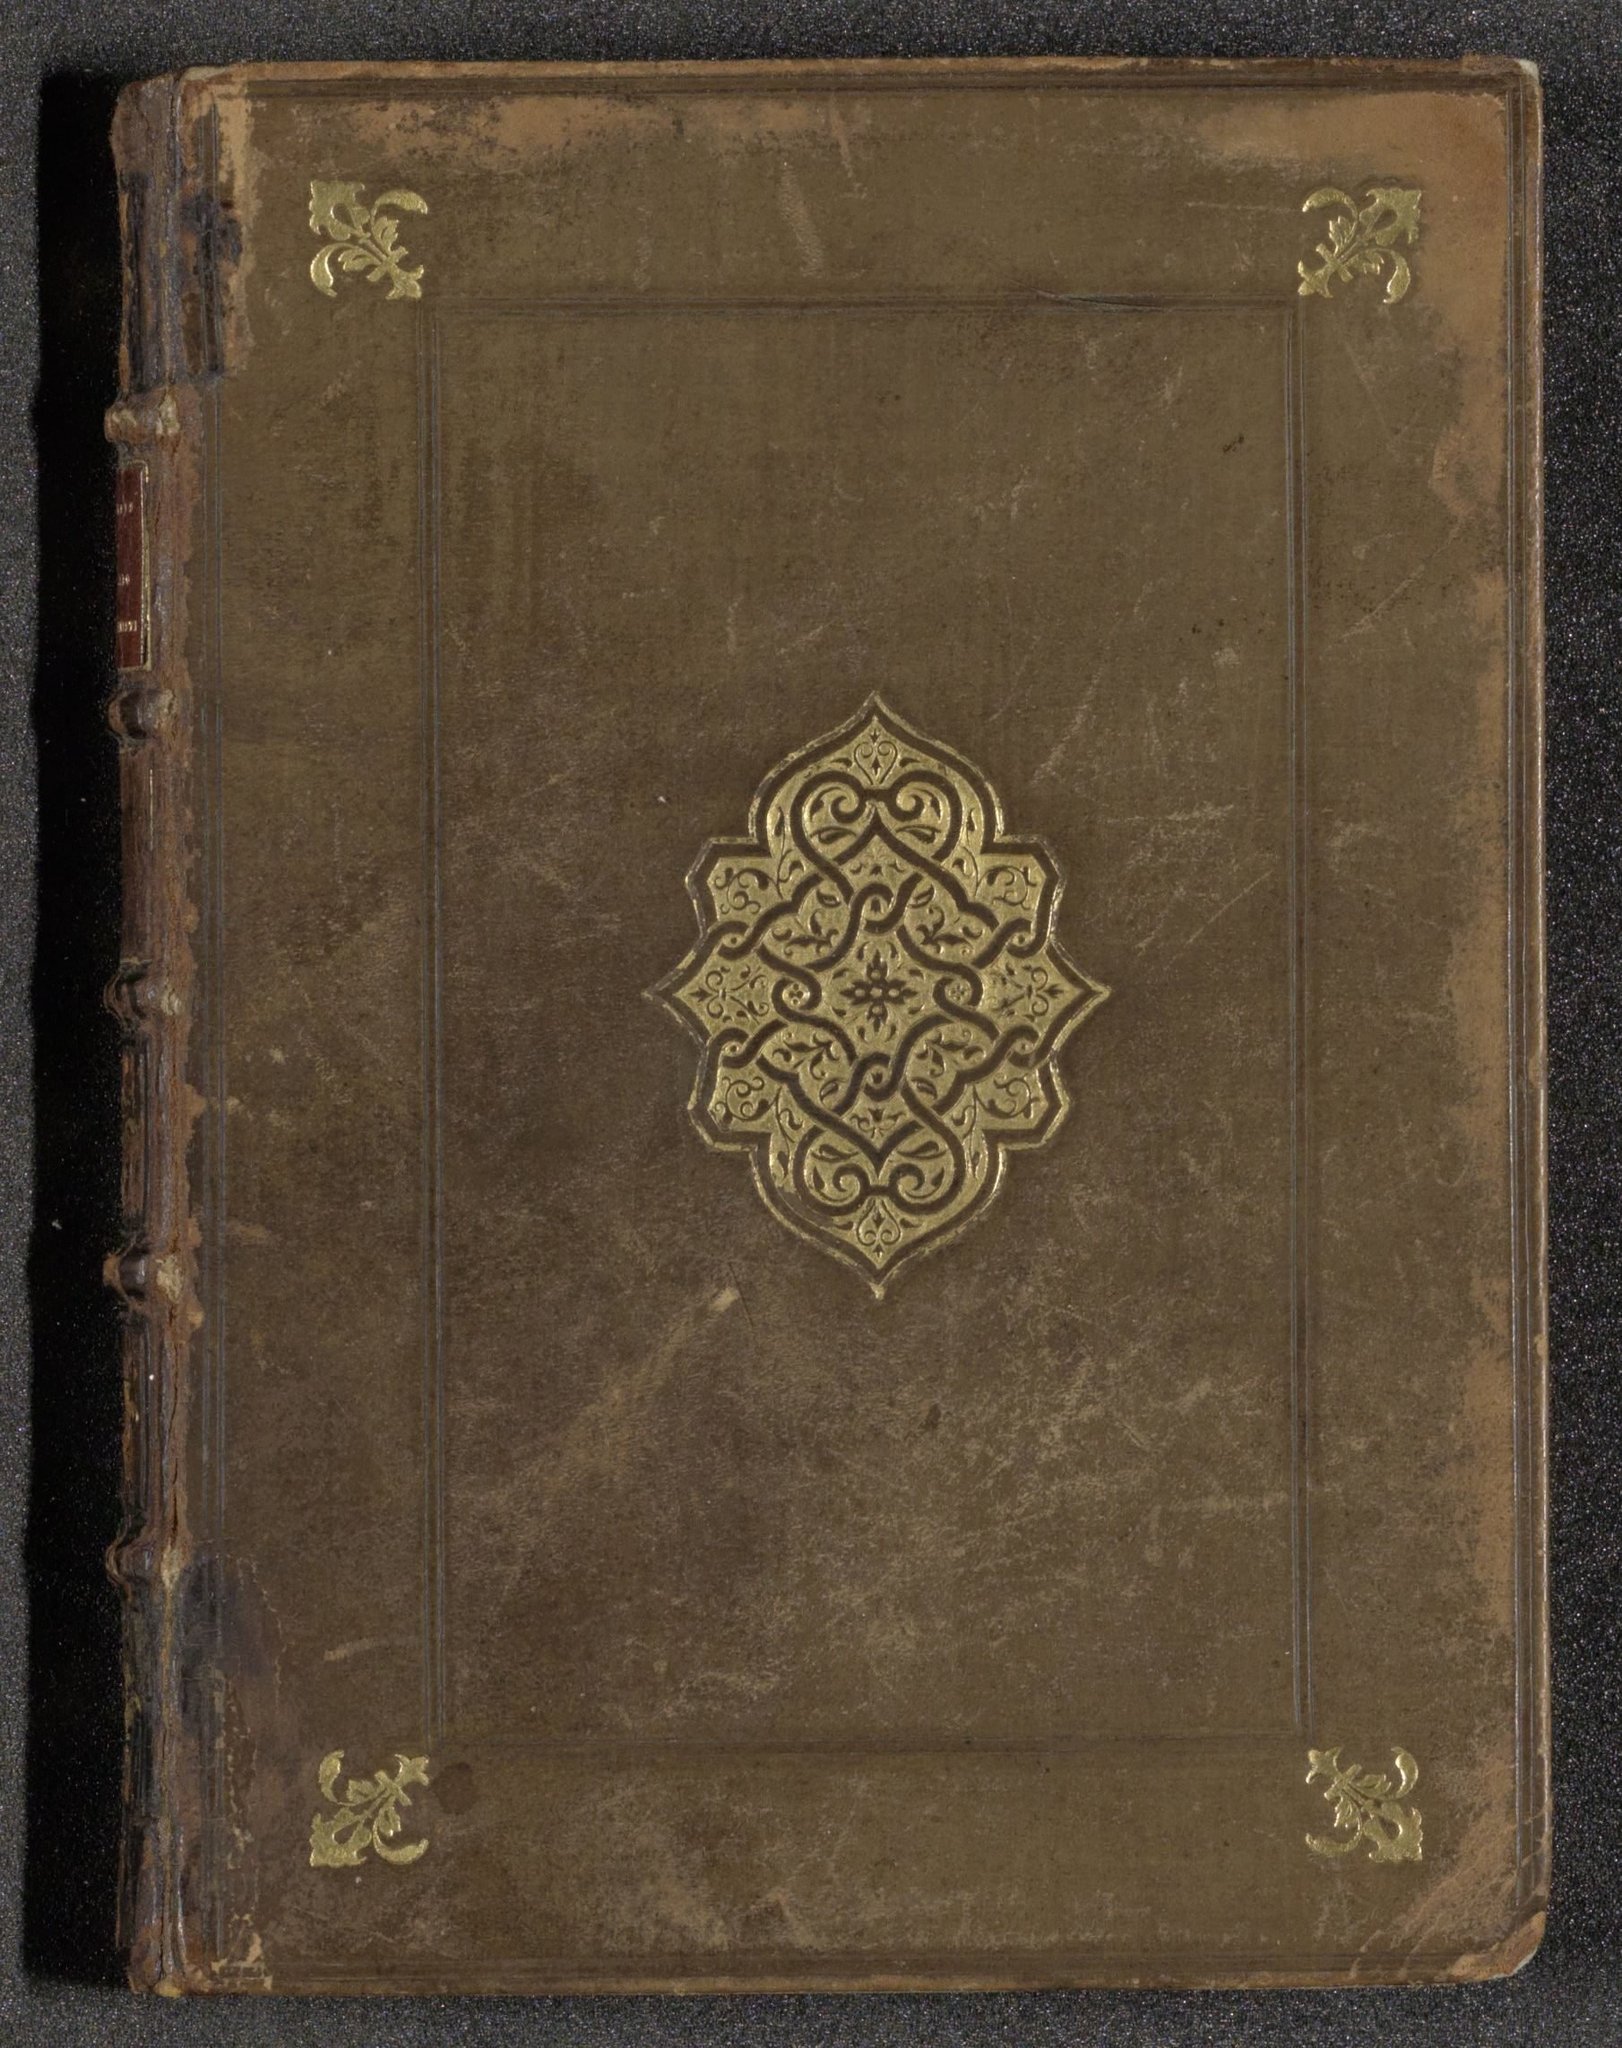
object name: book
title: Alardvs Passio Jesv Christi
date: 1523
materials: leather, paper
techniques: bookbinding, printing, letterpress printing, marbling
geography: amsterdam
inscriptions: collector's mark: Lugt 2166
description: Boek in het Latijn over de Passie van Christus. Het boek bevat een serie prenten over de christelijke heilsgeschiedenis: van de zondeval van Adam en Eva en de verdrijving uit het paradijs, de geboorte van Christus, het leven van Christus, de Passie van Christus tot aan Pinksteren. De teksten zijn verzameld door de humanist Alardus van Amsterdam. De bloemlezing werd op verzoek van de Amsterdamse koopman Pompejus Occo samengesteld uit beschrijvingen van Christus' Passie door diverse auteurs uit de oudheid en latere auteurs, onder wie Petrarca en Murmellius. In goud gestempelde kalfsleren band met dekbladen van marmerpapier.